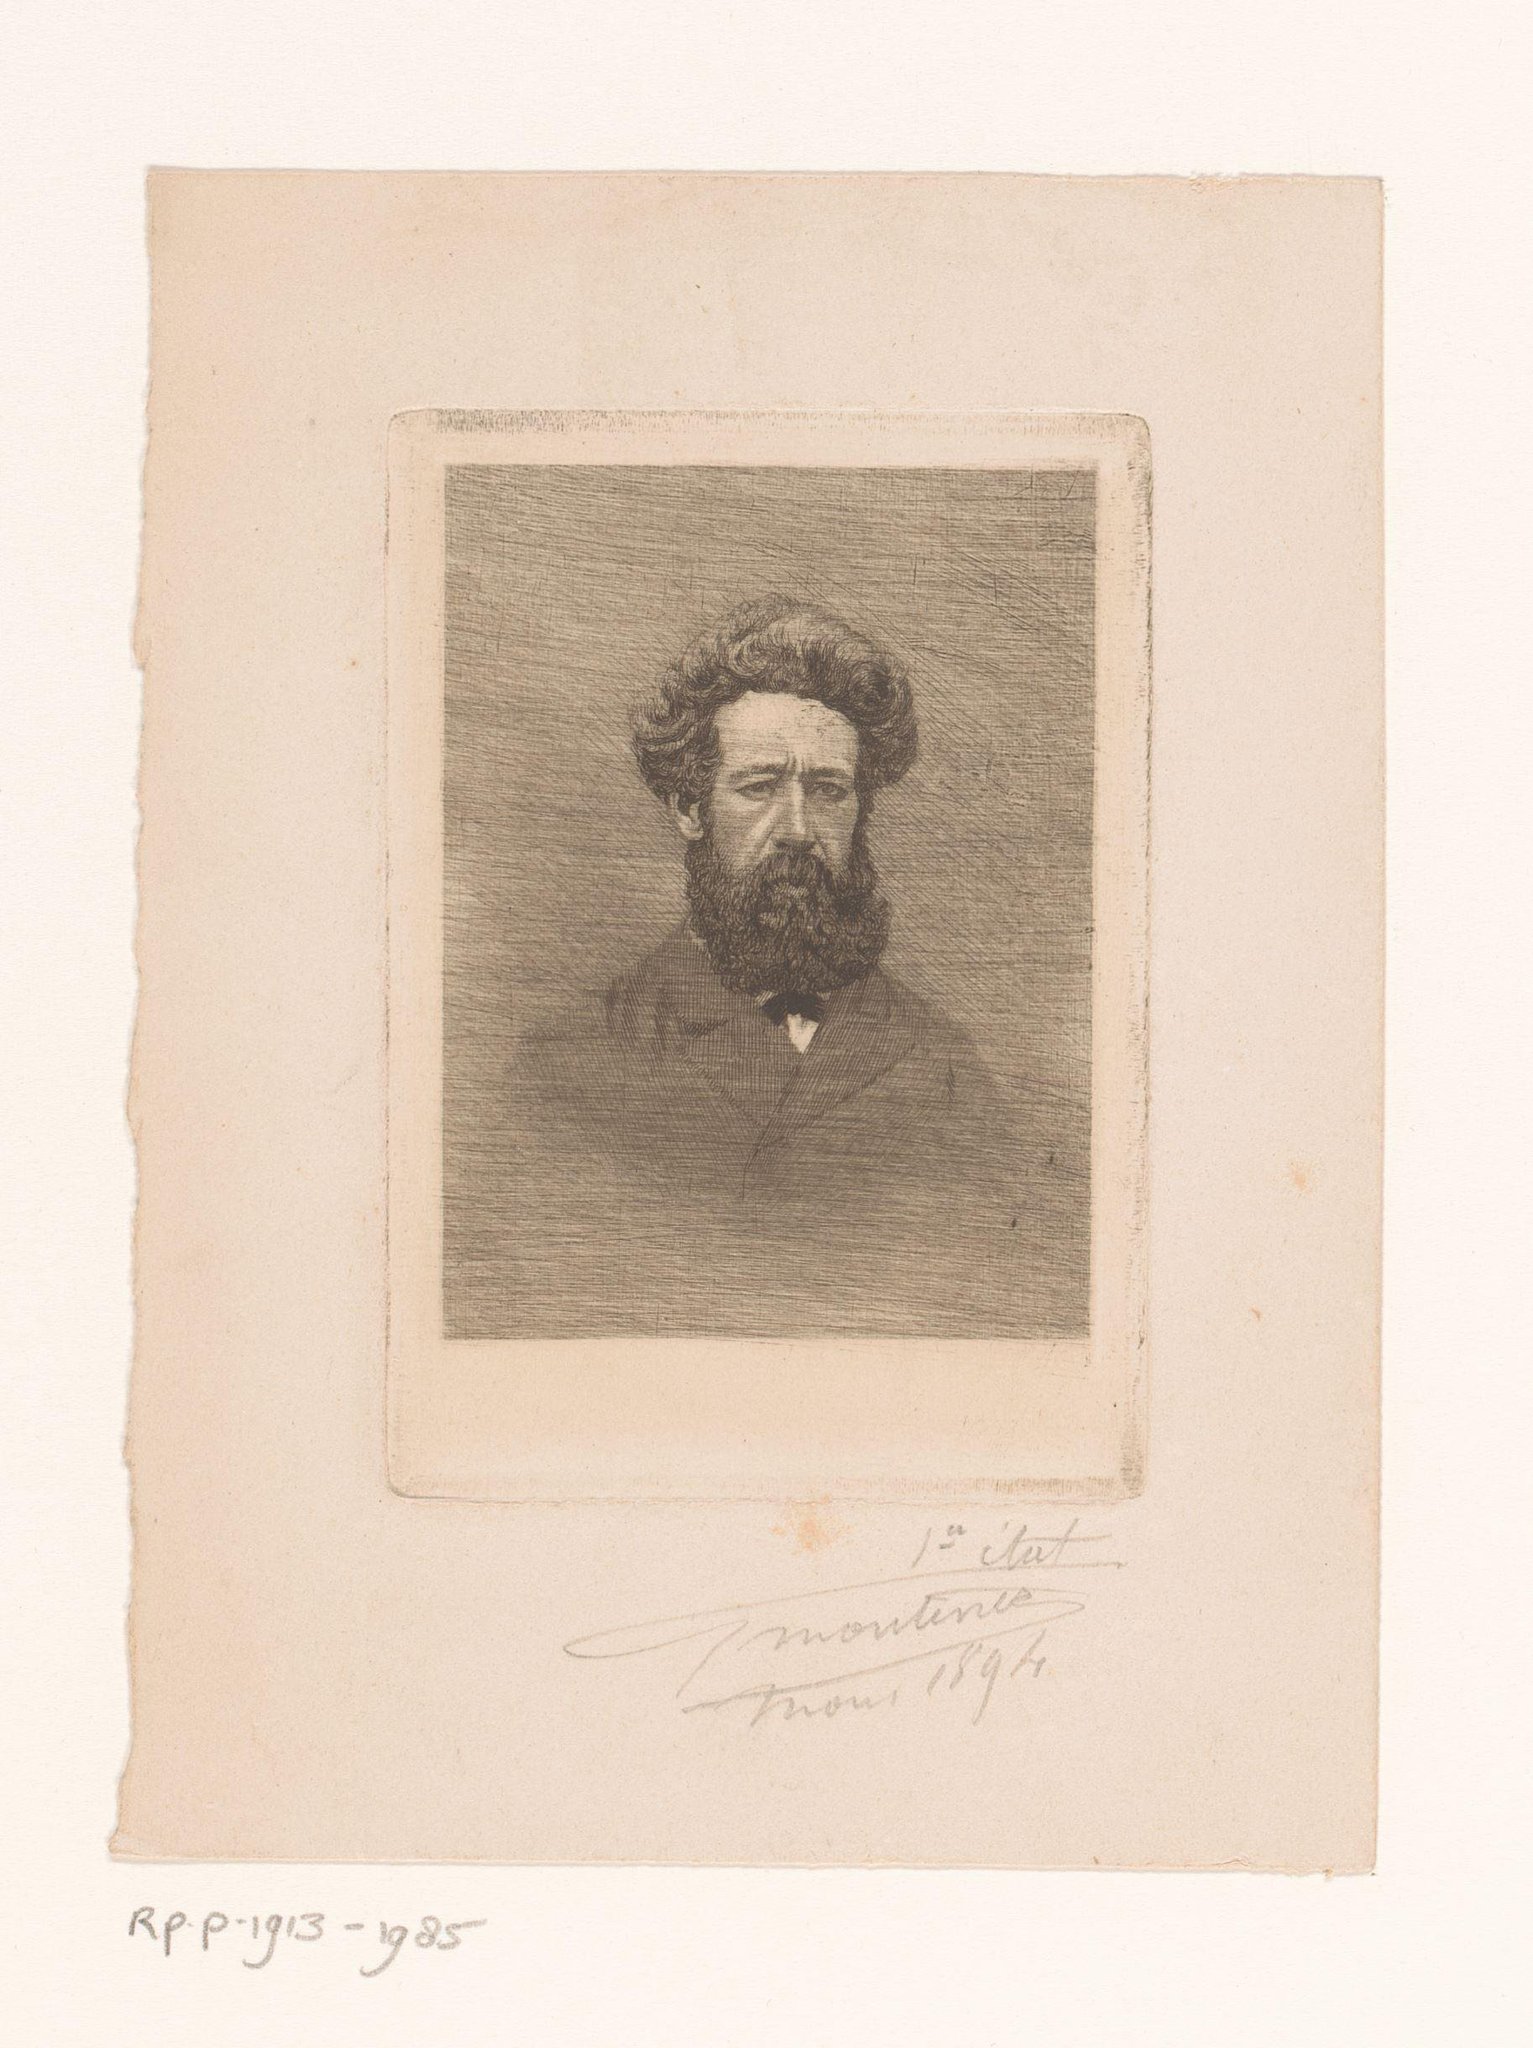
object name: print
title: Portret van een onbekende man, mogelijk Détail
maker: georges montenez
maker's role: print maker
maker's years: 1873-1930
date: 1894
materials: paper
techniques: etching, intaglio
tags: adult man, historical persons, beard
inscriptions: collector's mark: Lugt 2228, inscription: ‘1e état; Mons 1894’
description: In de inventaris getiteld: Portret van Mr. Détail.